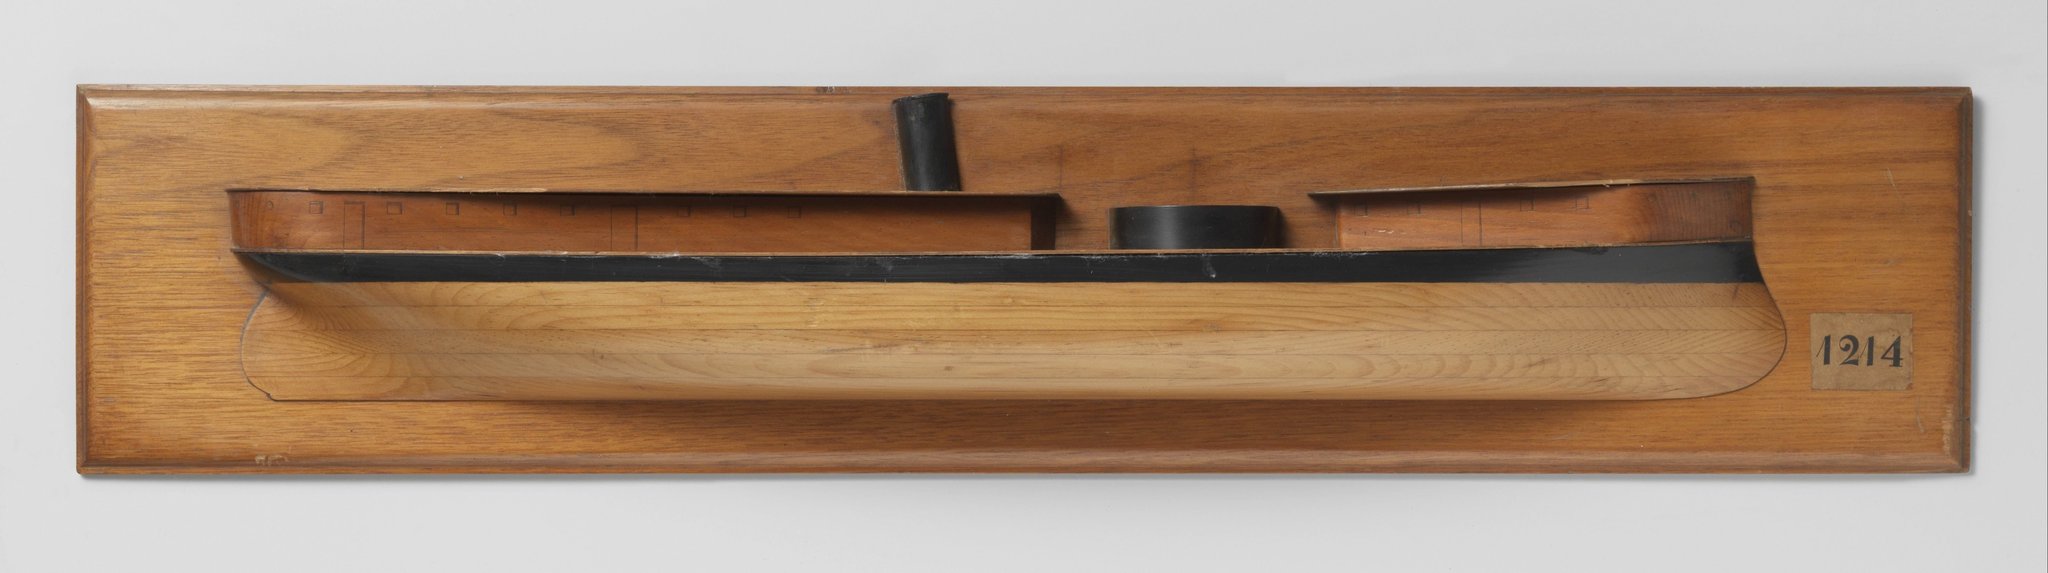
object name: ship model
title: Half Model of an Ironclad Ram Ship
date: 1865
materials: wood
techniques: polychromy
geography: birkenhead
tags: france, england, toulon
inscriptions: label, bottom right: ‘1214’ former inventory label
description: Dit model is samen met een gelijkaardig model van een monitor (NG-MC-1216) door Laird Brothers in 1865 aan de Nederlandse minister van Marine aangeboden als voorontwerpen voor de eerste generatie gepantserde schepen van de Nederlandse Marine. Twee Nederlandse schepen zijn naar dit ontwerp gebouwd: de Stier, lang 59.43 m, door Laird Brothers in England in 1868 en de Schorpioen, lang 59.68 m, in een iets gewijzigde vorm, door de Société des Forges et des Chantiers Mediterrannées in Toulon in Frankrijk, ook in 1868.